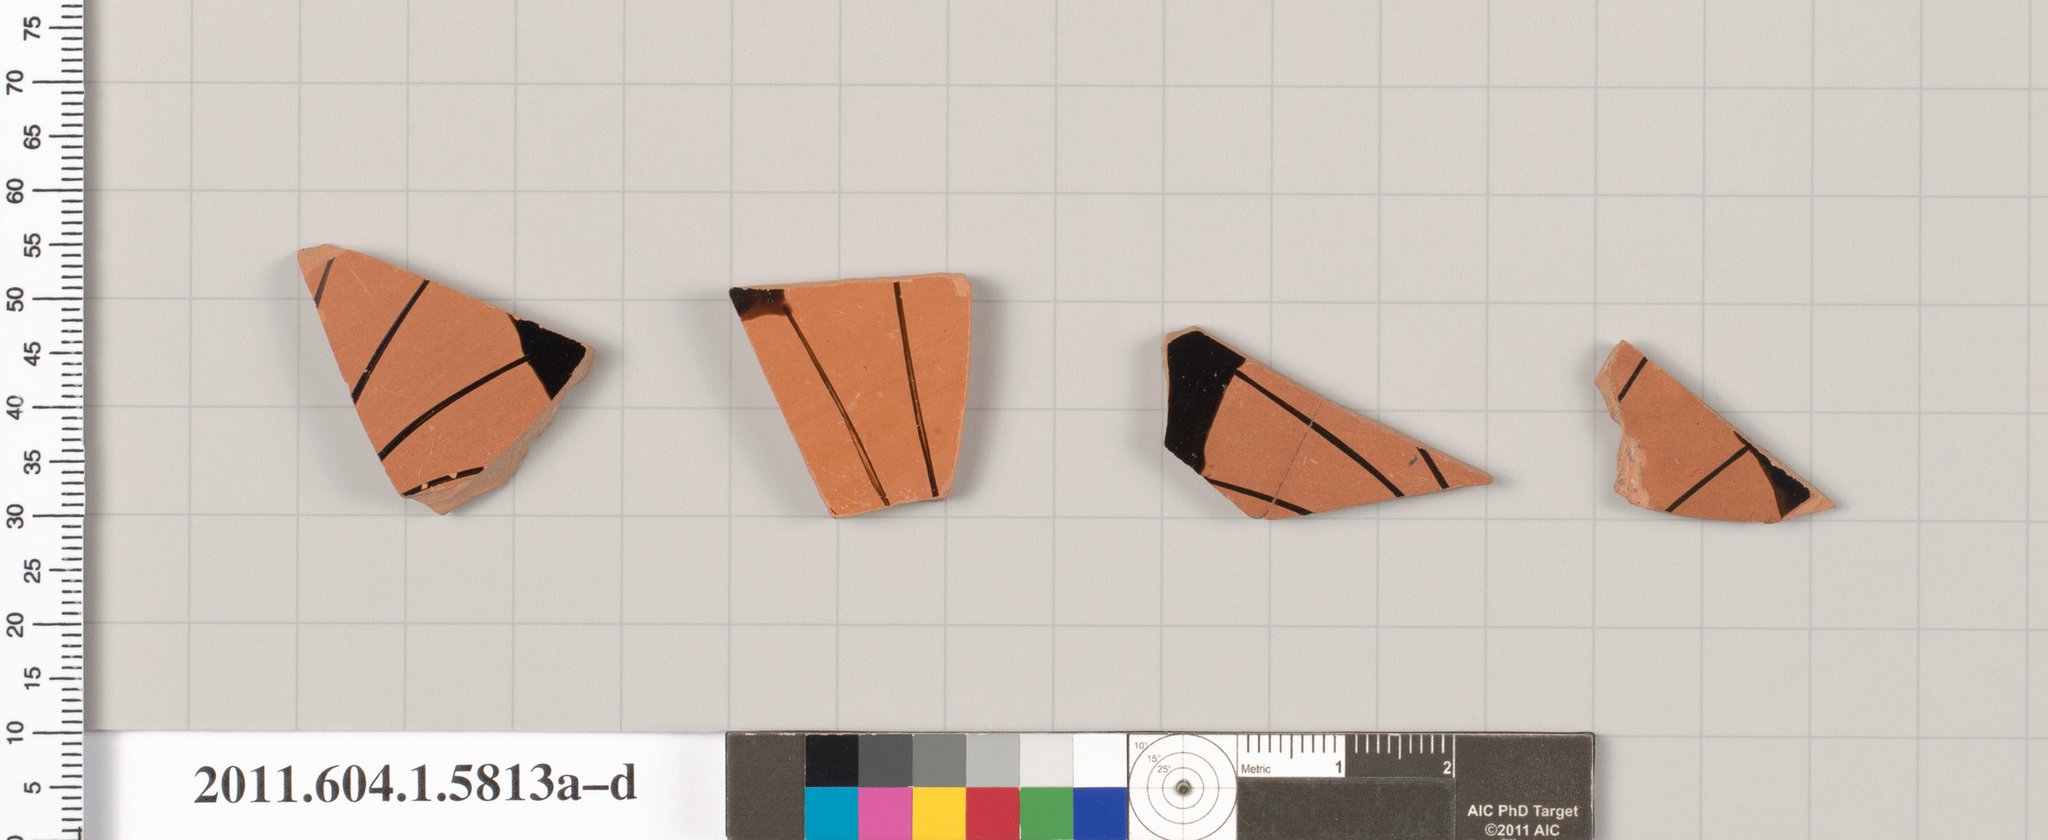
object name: kylix fragment, eye cup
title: Terracotta fragments of kylikes: eye-cups (drinking cups)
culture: greek, attic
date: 520-510 BCE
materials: terracotta